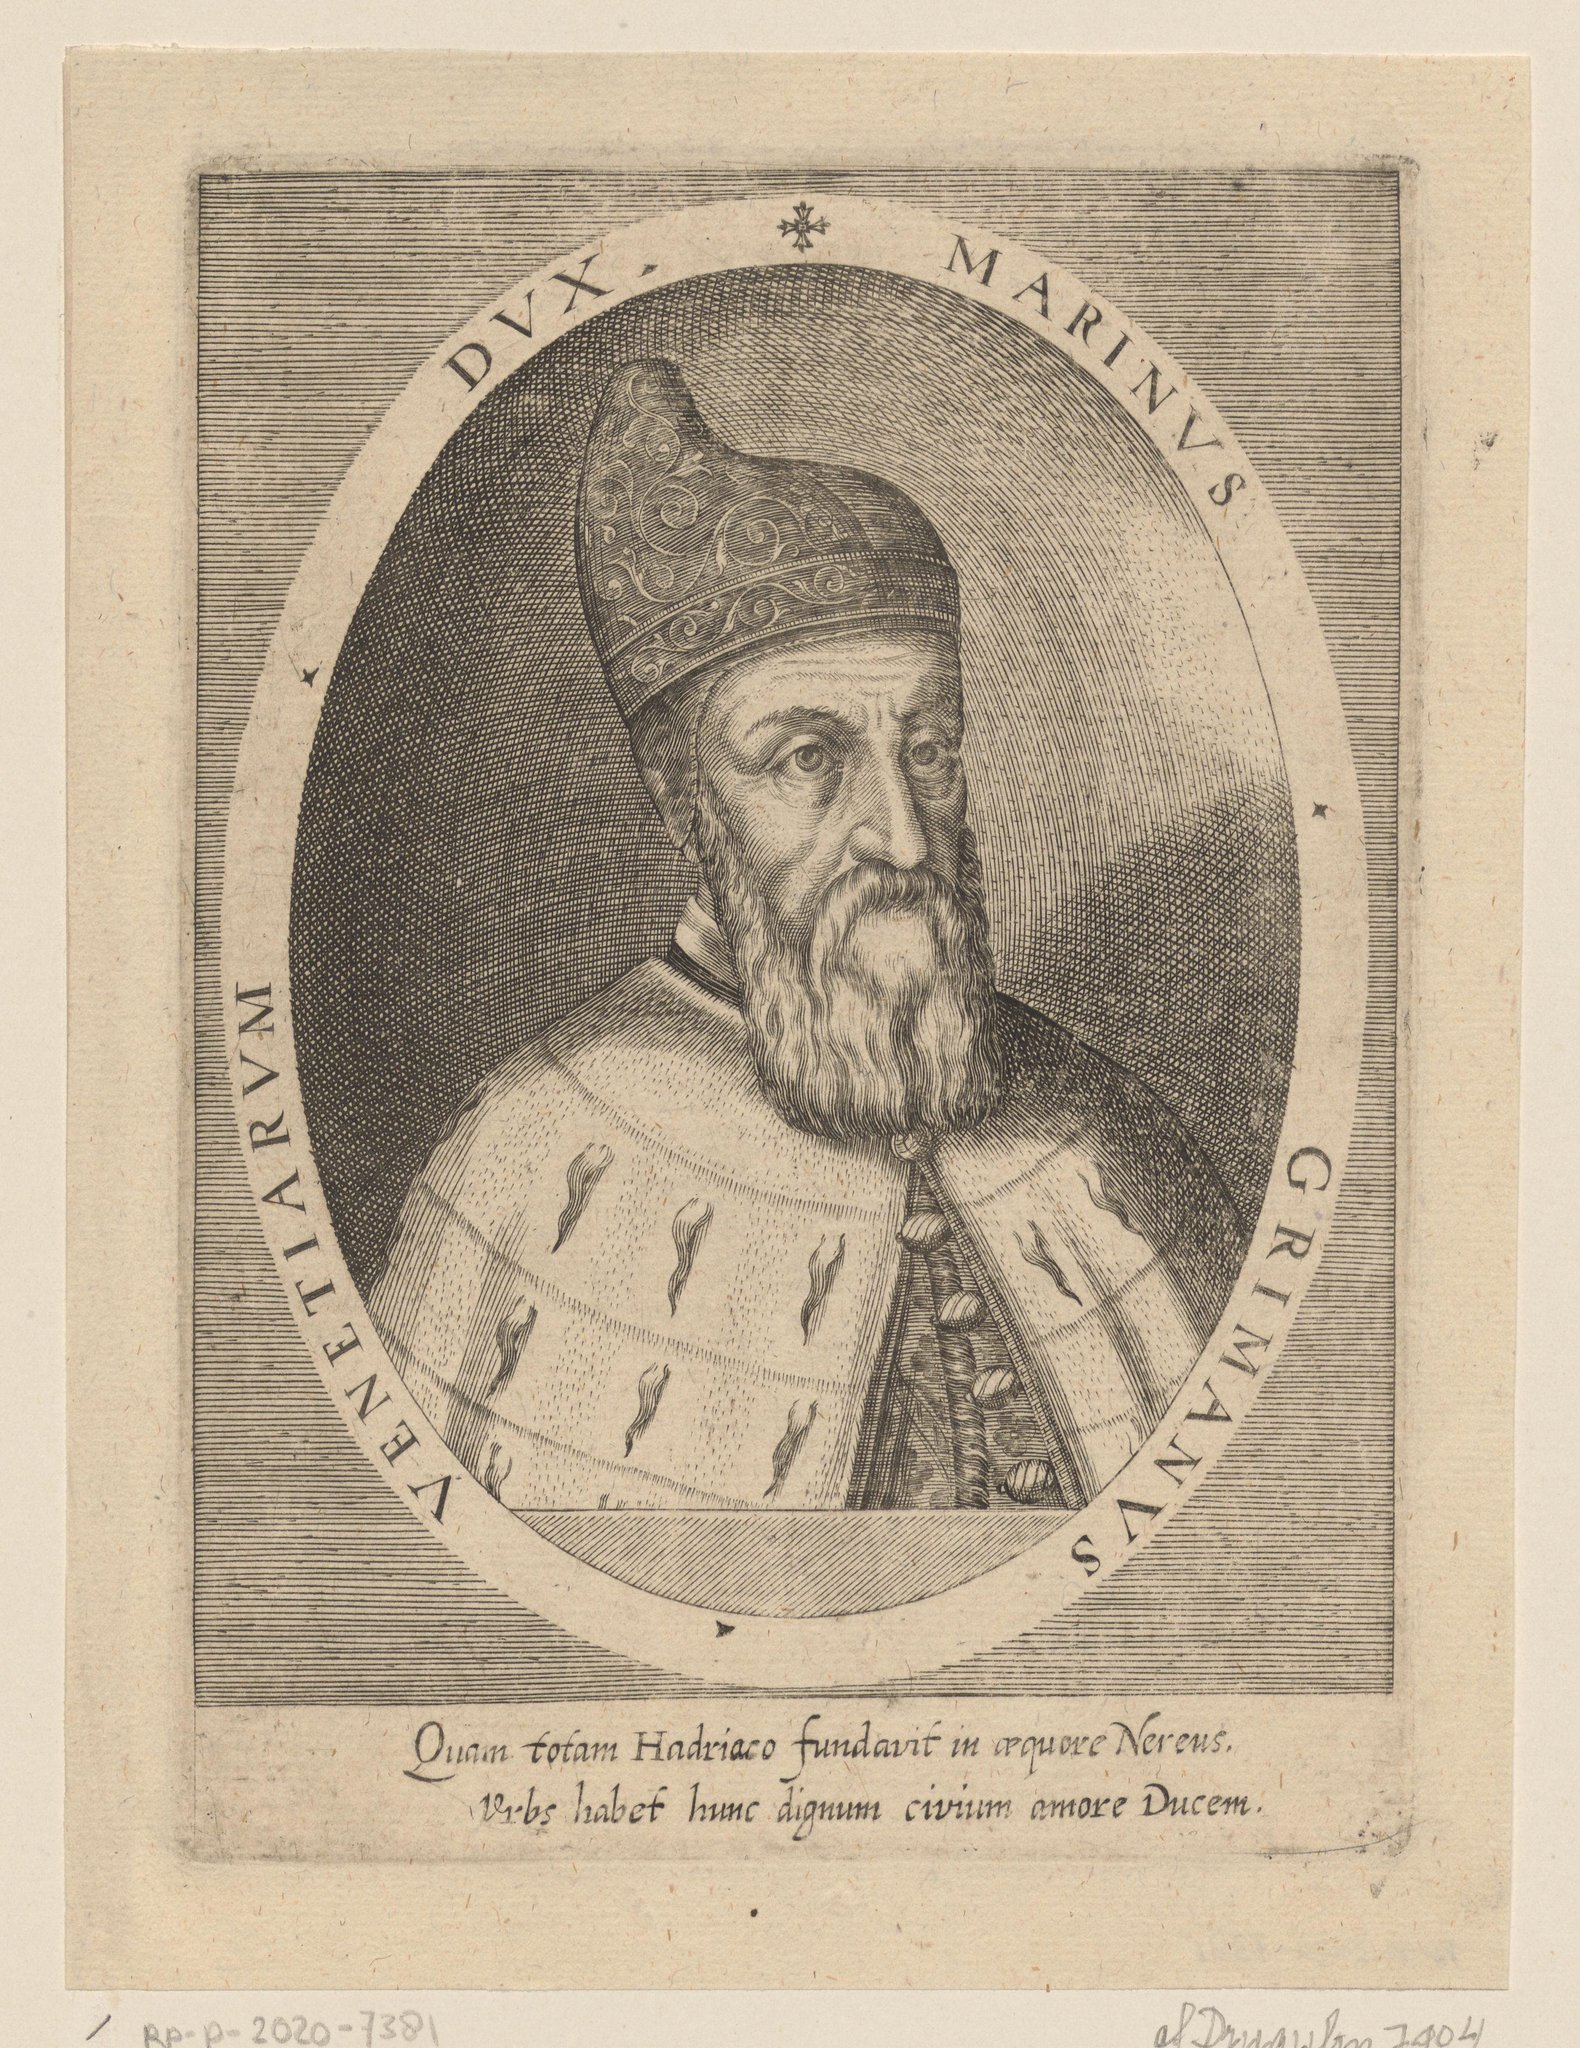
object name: print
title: Portret van Marino Grimani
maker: dominicus custos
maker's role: print maker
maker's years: 1560-1615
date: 1600-1604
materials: paper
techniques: engraving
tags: historical persons, politician, e.g. party leader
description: Tekst in het Latijn in de ondermarge en in de omlijsting.